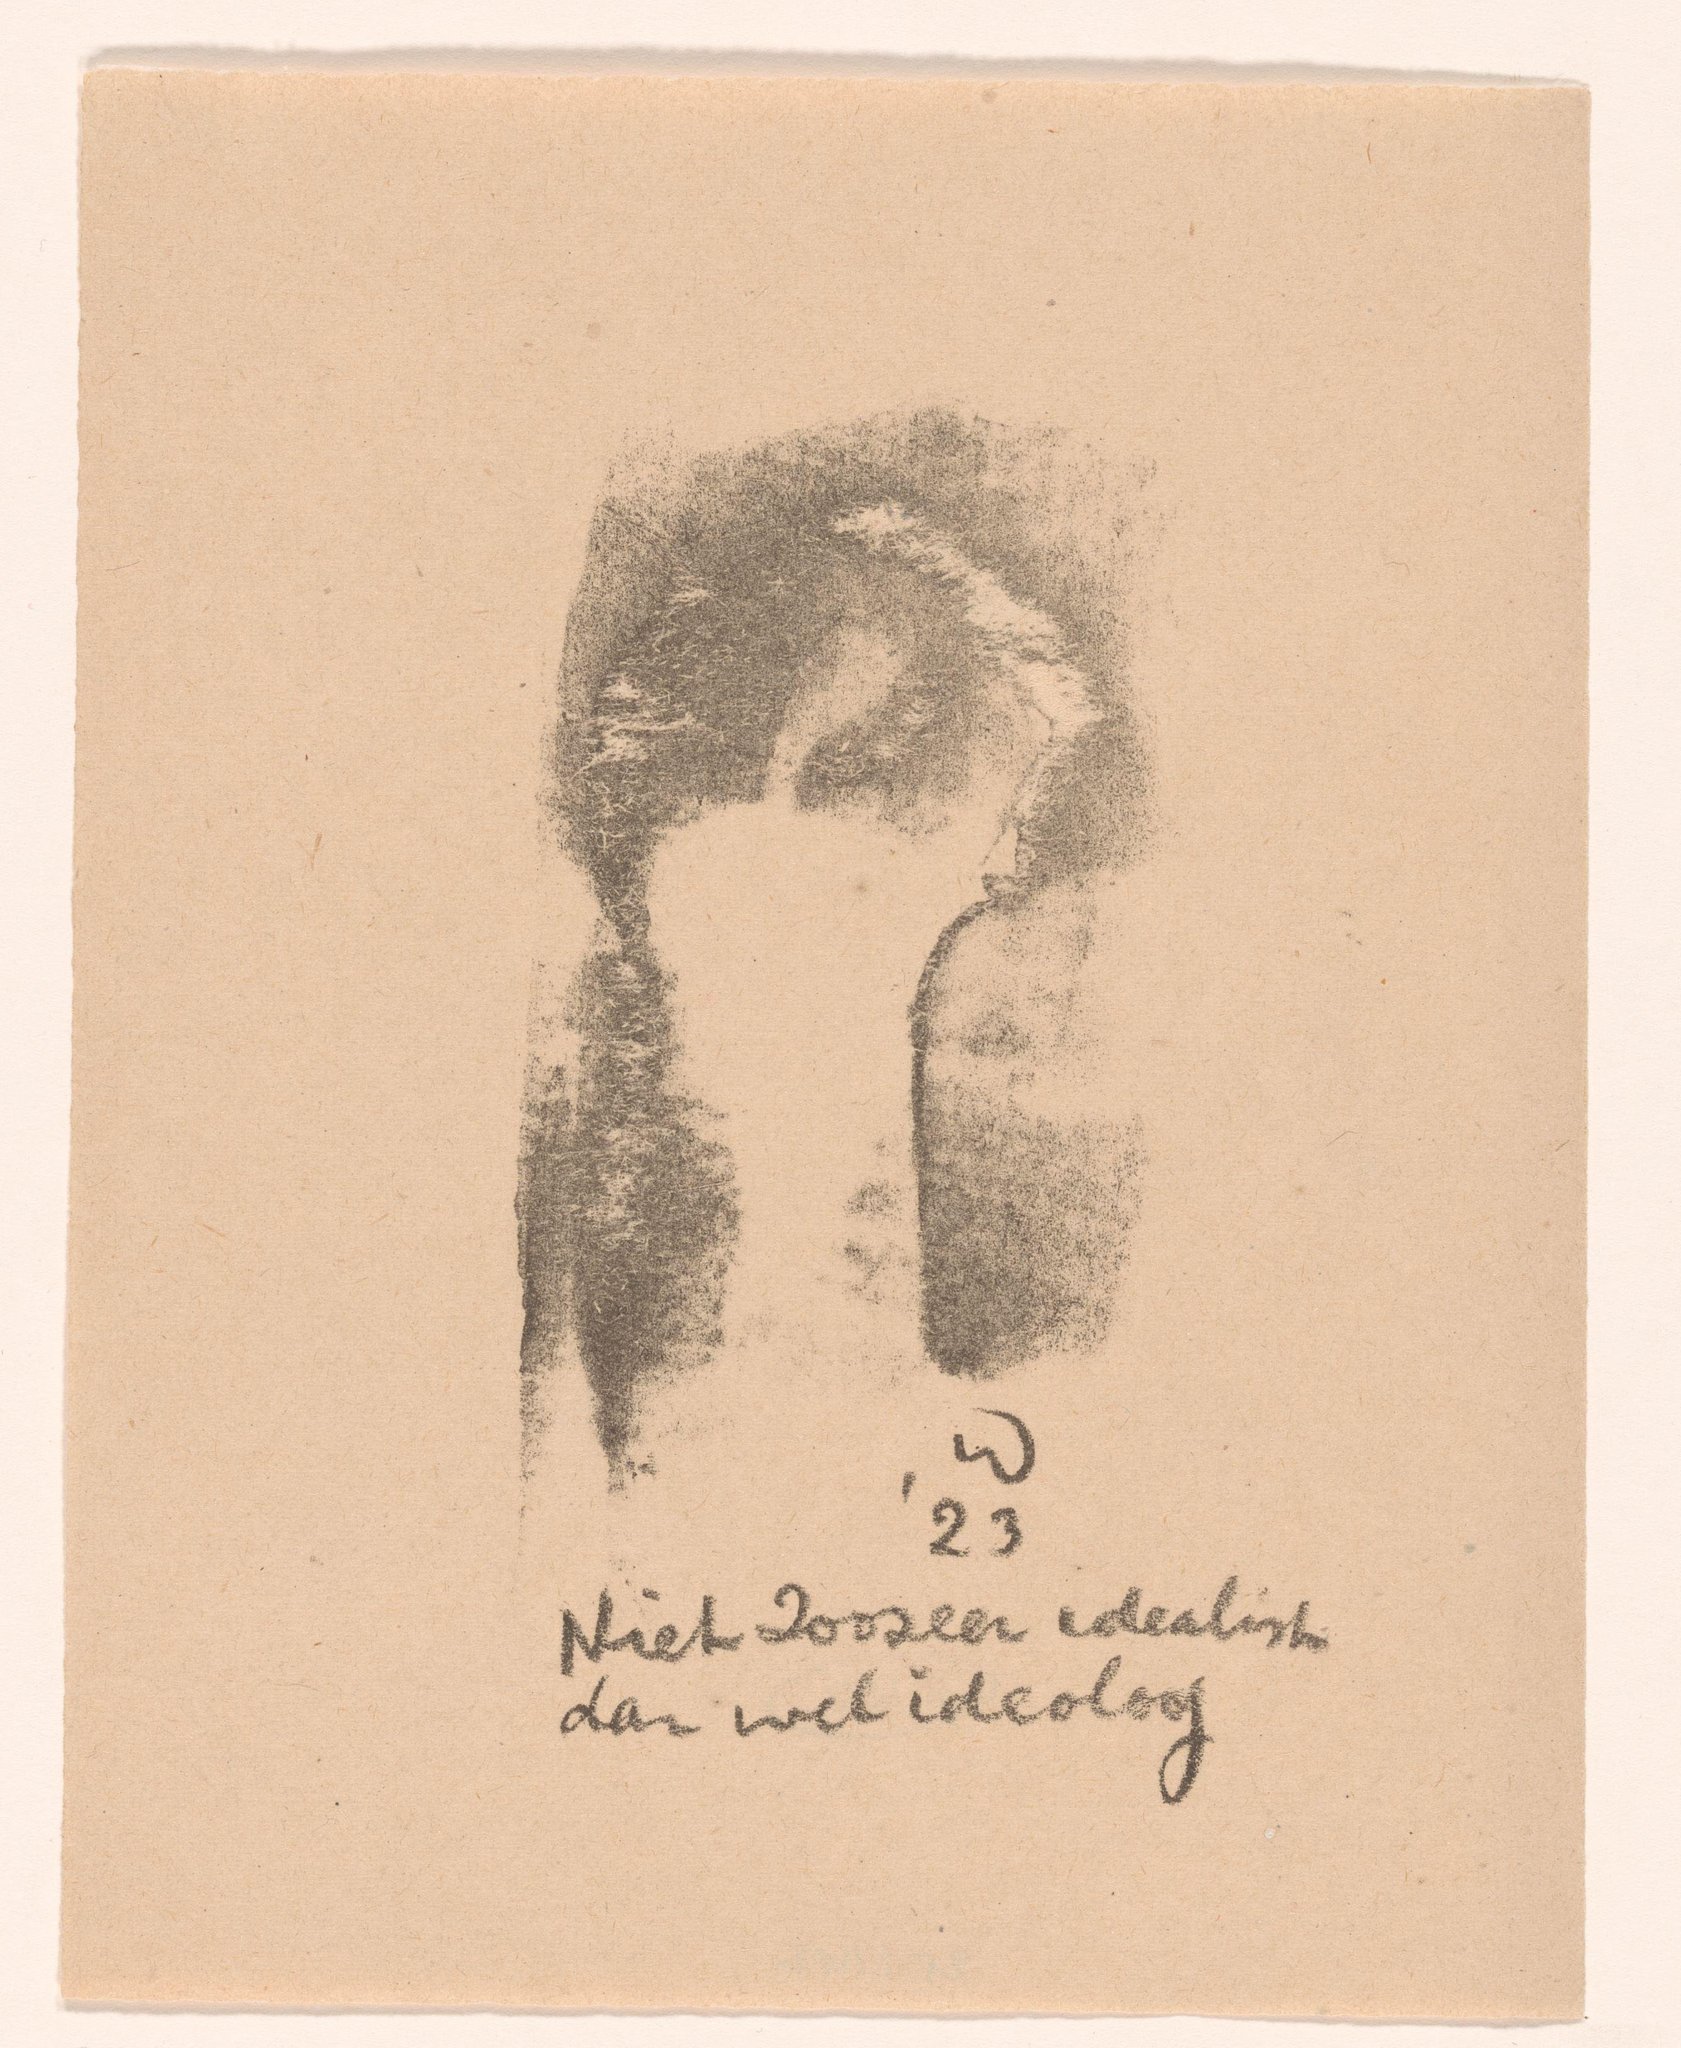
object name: print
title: Niet zoozeer idealist dan wel ideoloog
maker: erich wichmann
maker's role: print maker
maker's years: 1890-1929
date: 1923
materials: paper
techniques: lithograph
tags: caricatures (human types)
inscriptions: collector's mark: Lugt 2228